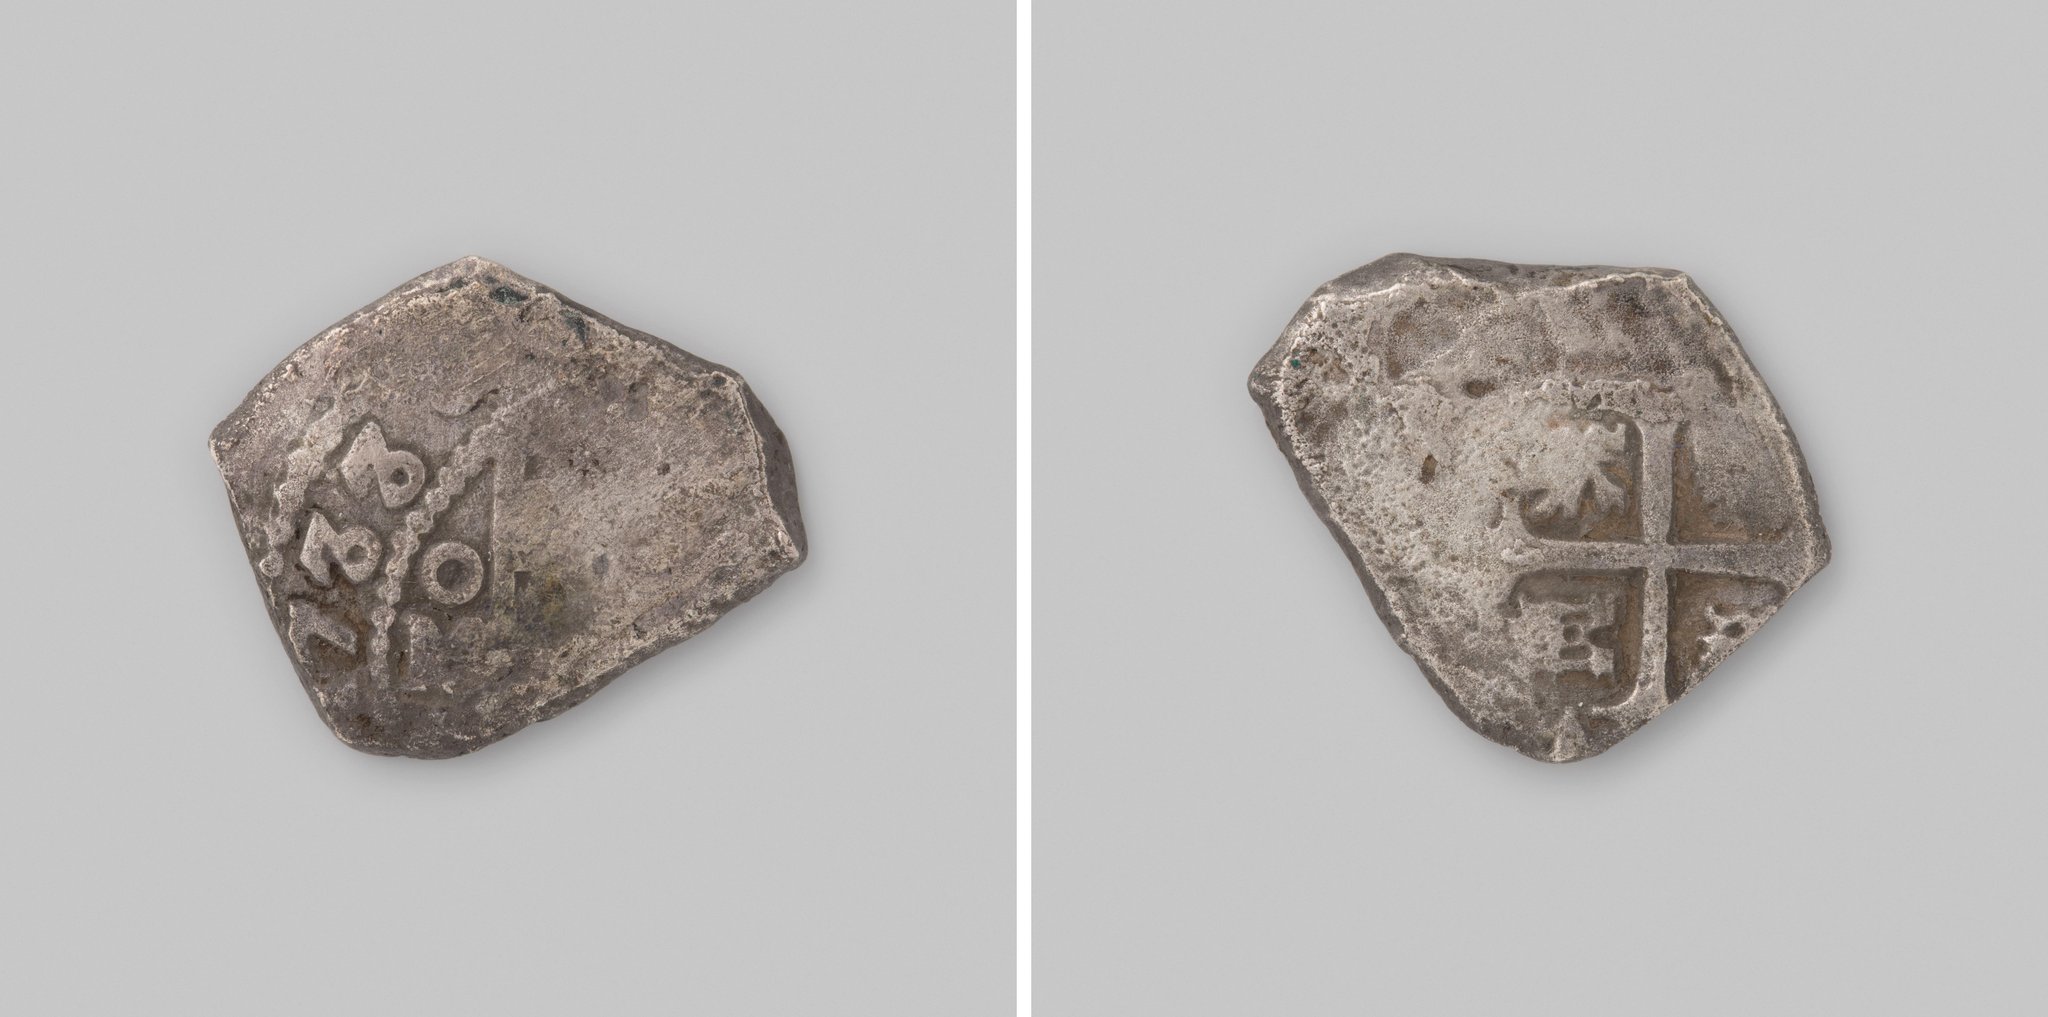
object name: vier reaal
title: Reaal van vieren, geslagen te Mexico, munt uit het wrak van de Oost-Indiëvaarder 't Vliegend Hart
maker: francisco de la pena flores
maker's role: essayeur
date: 1733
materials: silver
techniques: striking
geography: mexico city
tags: filips v (koning van spanje)